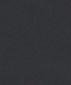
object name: painting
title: Hermanus Boerhaave (1668-1738), Professor of Medicine at the University of Leiden, with his Wife Maria Drolenvaux (1686-1746) and their Daughter Johanna Maria (1712-91)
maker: aert de gelder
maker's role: draughtsman, painter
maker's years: 1645-1727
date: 1720-1725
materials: canvas, oil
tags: leiden, hermanus boerhaave, family group, especially parents with their child(ren), gripping someone by the hand or the wrist; clasped hands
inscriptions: signature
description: Familieportret van Hermanus Boerhaave, hoogleraar in de geneeskunde te Leiden, met zijn vrouw Maria Drolenvaux en hun dochter Johanna Maria, de latere gravin de Thoms. De personen zijn zittend en hand in hand geportretteerd, in fantasiekleding.